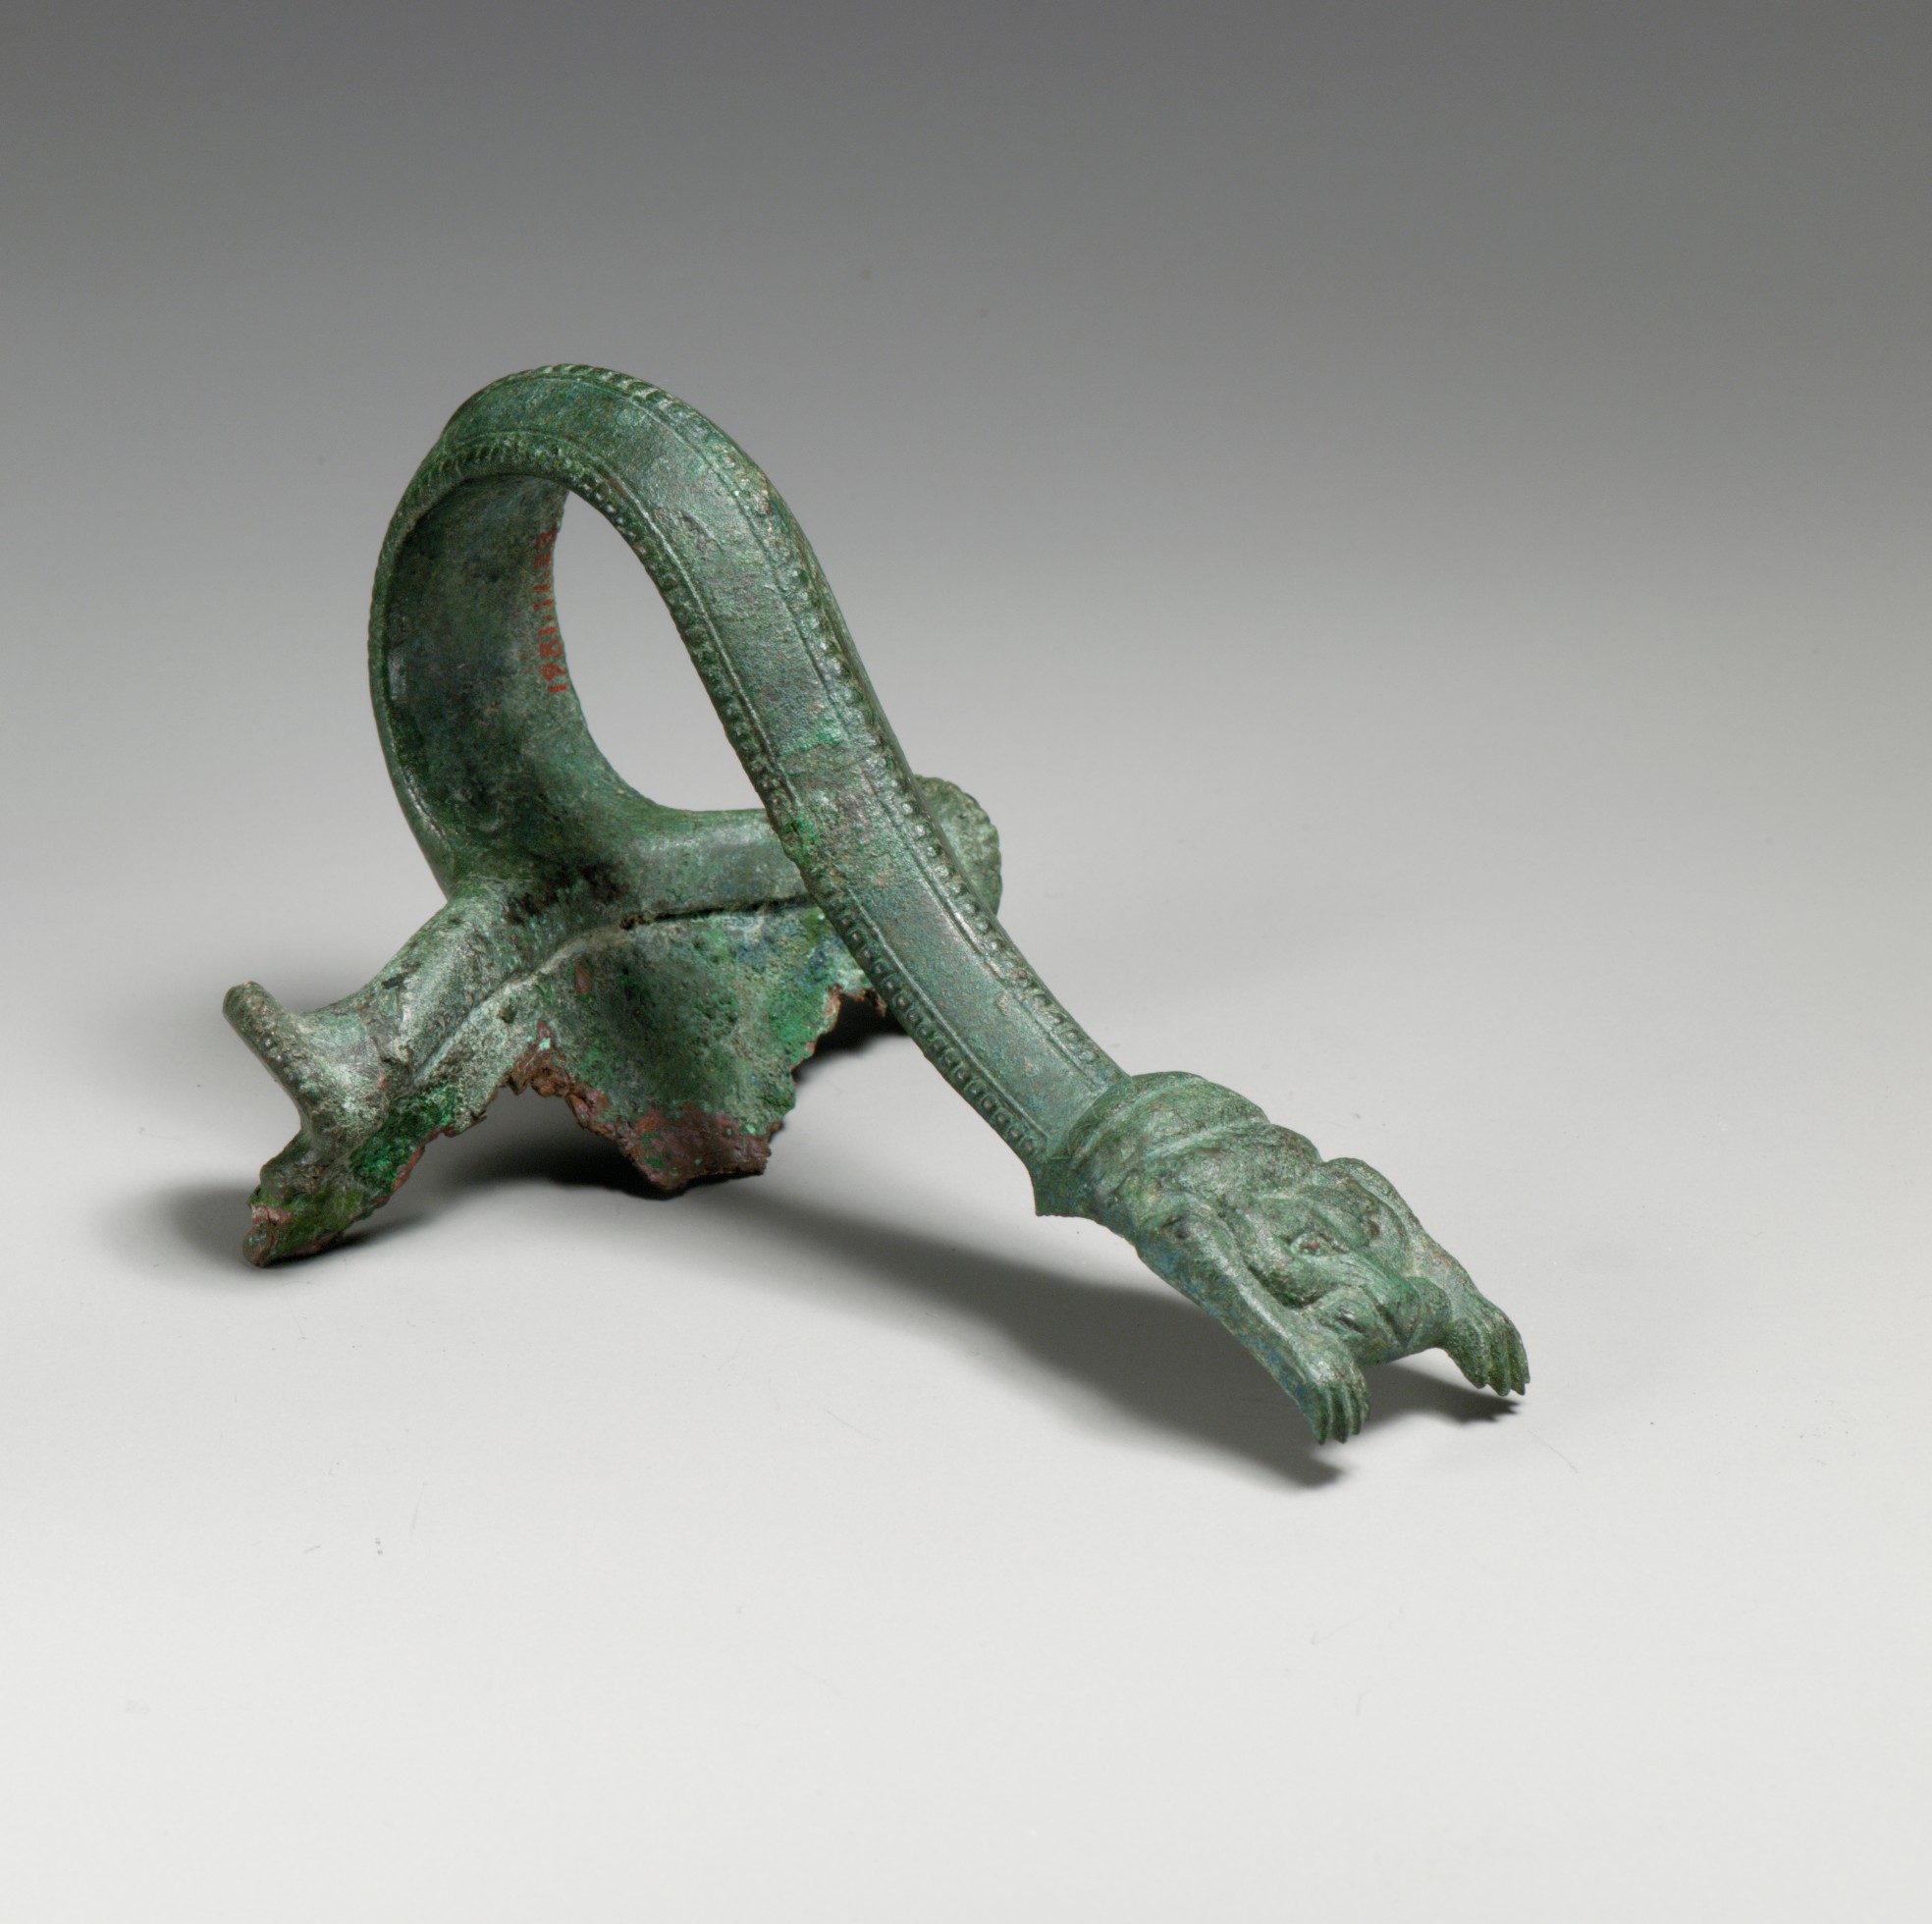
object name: handle of an oinochoe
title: Bronze handle of an oinochoe (jug)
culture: greek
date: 500-468 BCE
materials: bronze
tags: lions